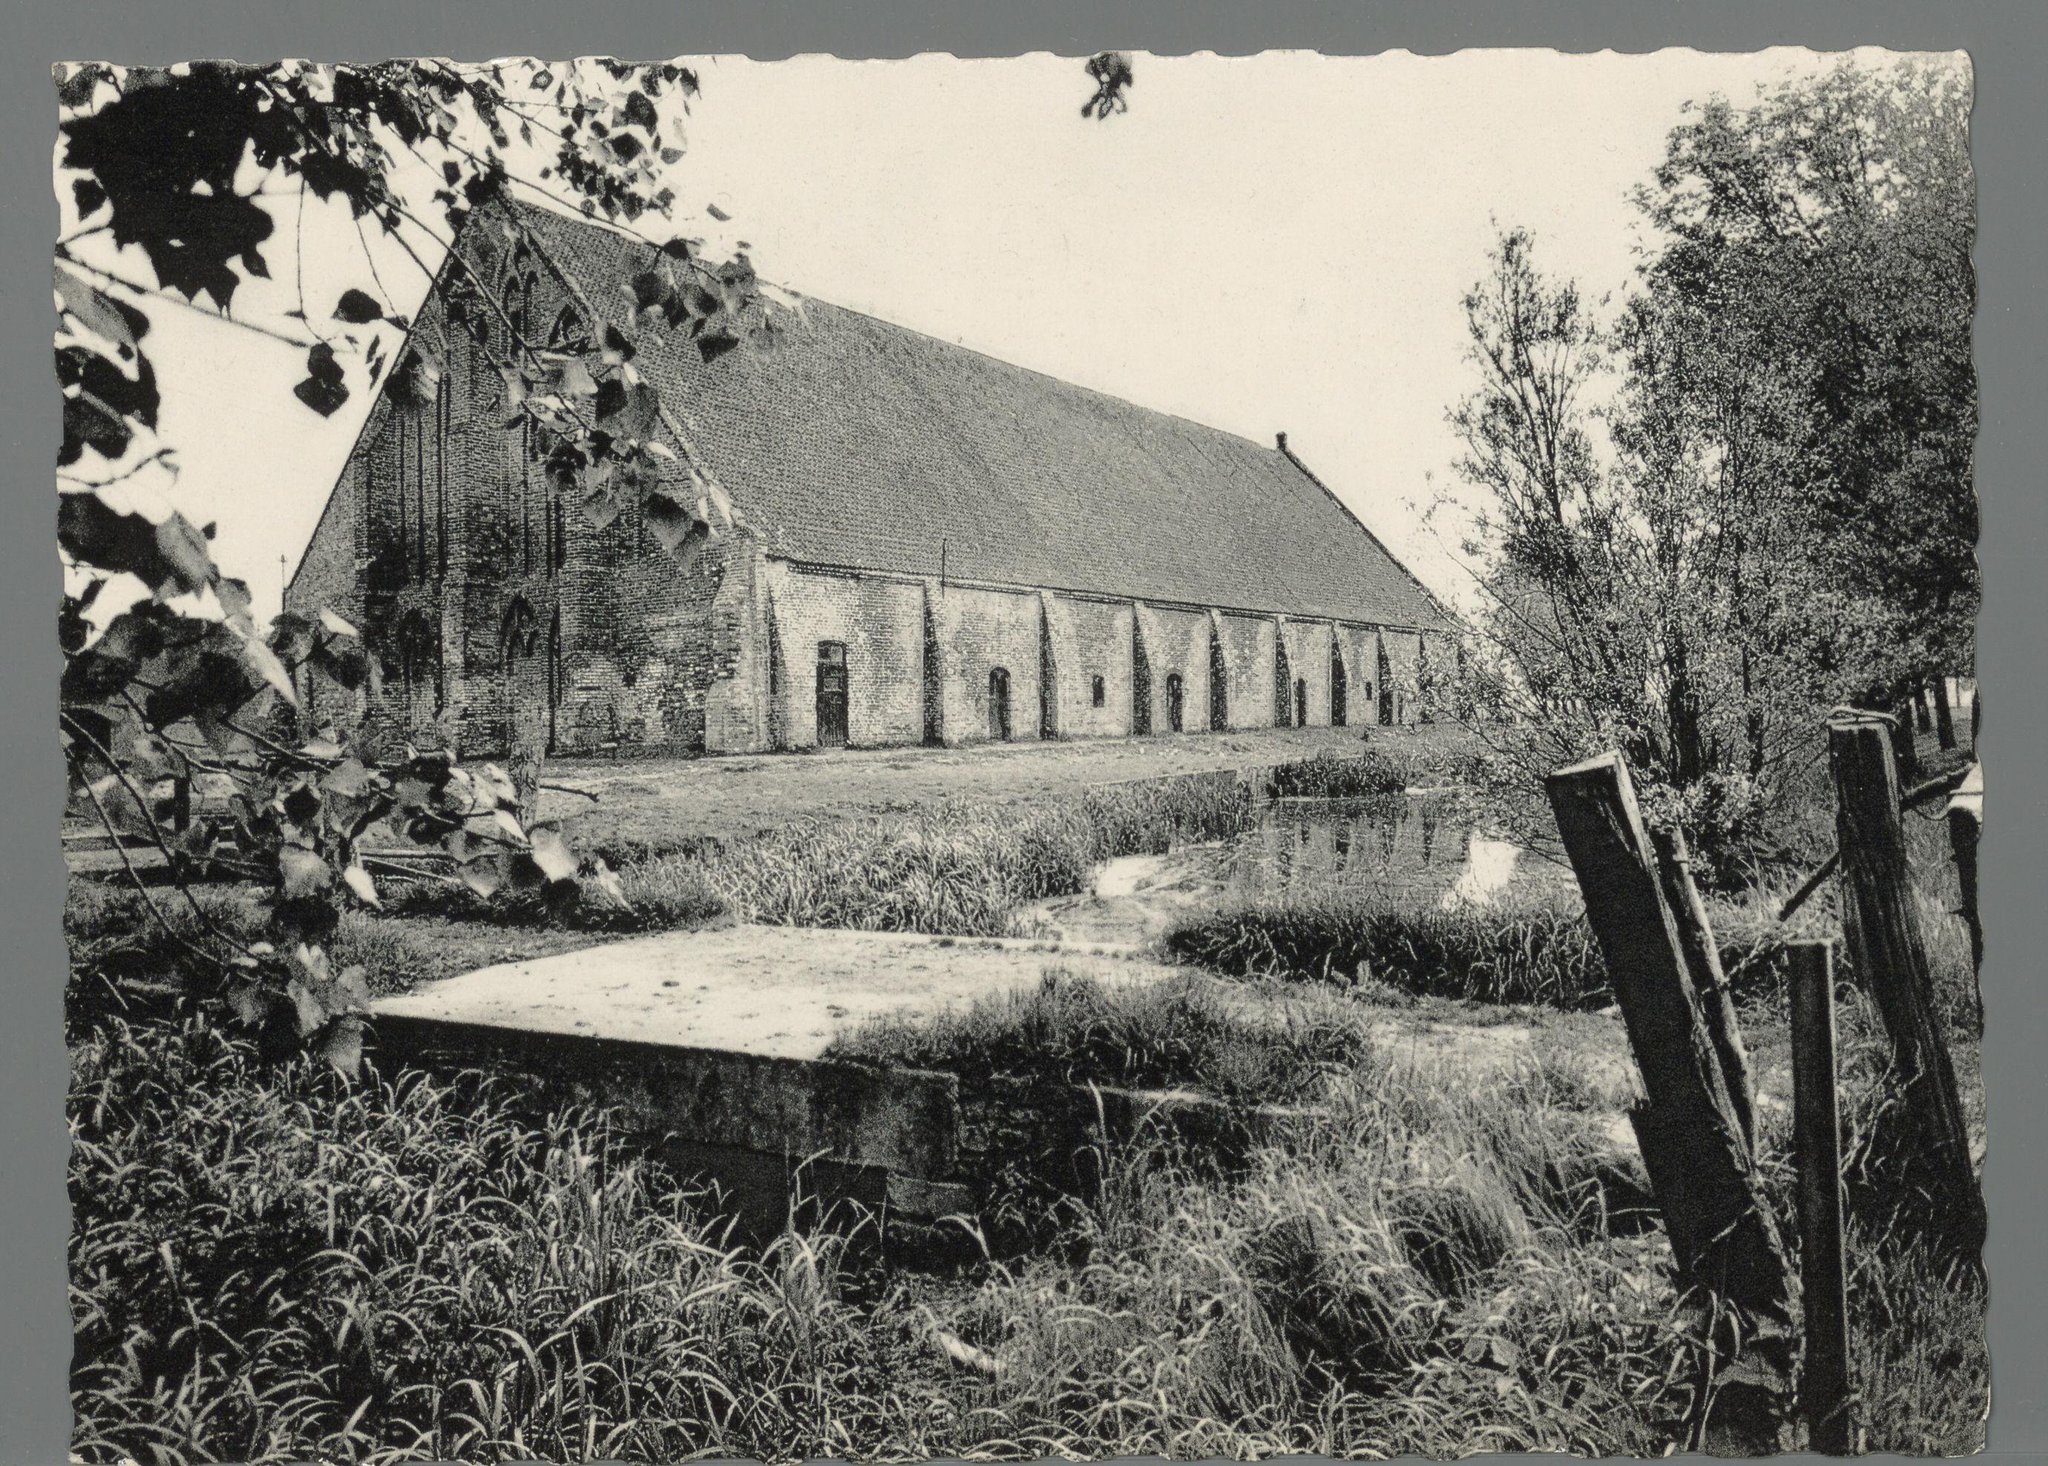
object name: photomechanical print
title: Lissewege. Monumentale schuur van de abdij Ter Doest XIIIe eeuw / Grange monumentale de l'abbaye de Ter Doest XIIIe siècle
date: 1929-1962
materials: cardboard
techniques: photograph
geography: brussels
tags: barn, landscapes with waters, waterscapes, seascapes (in the temperate zone)